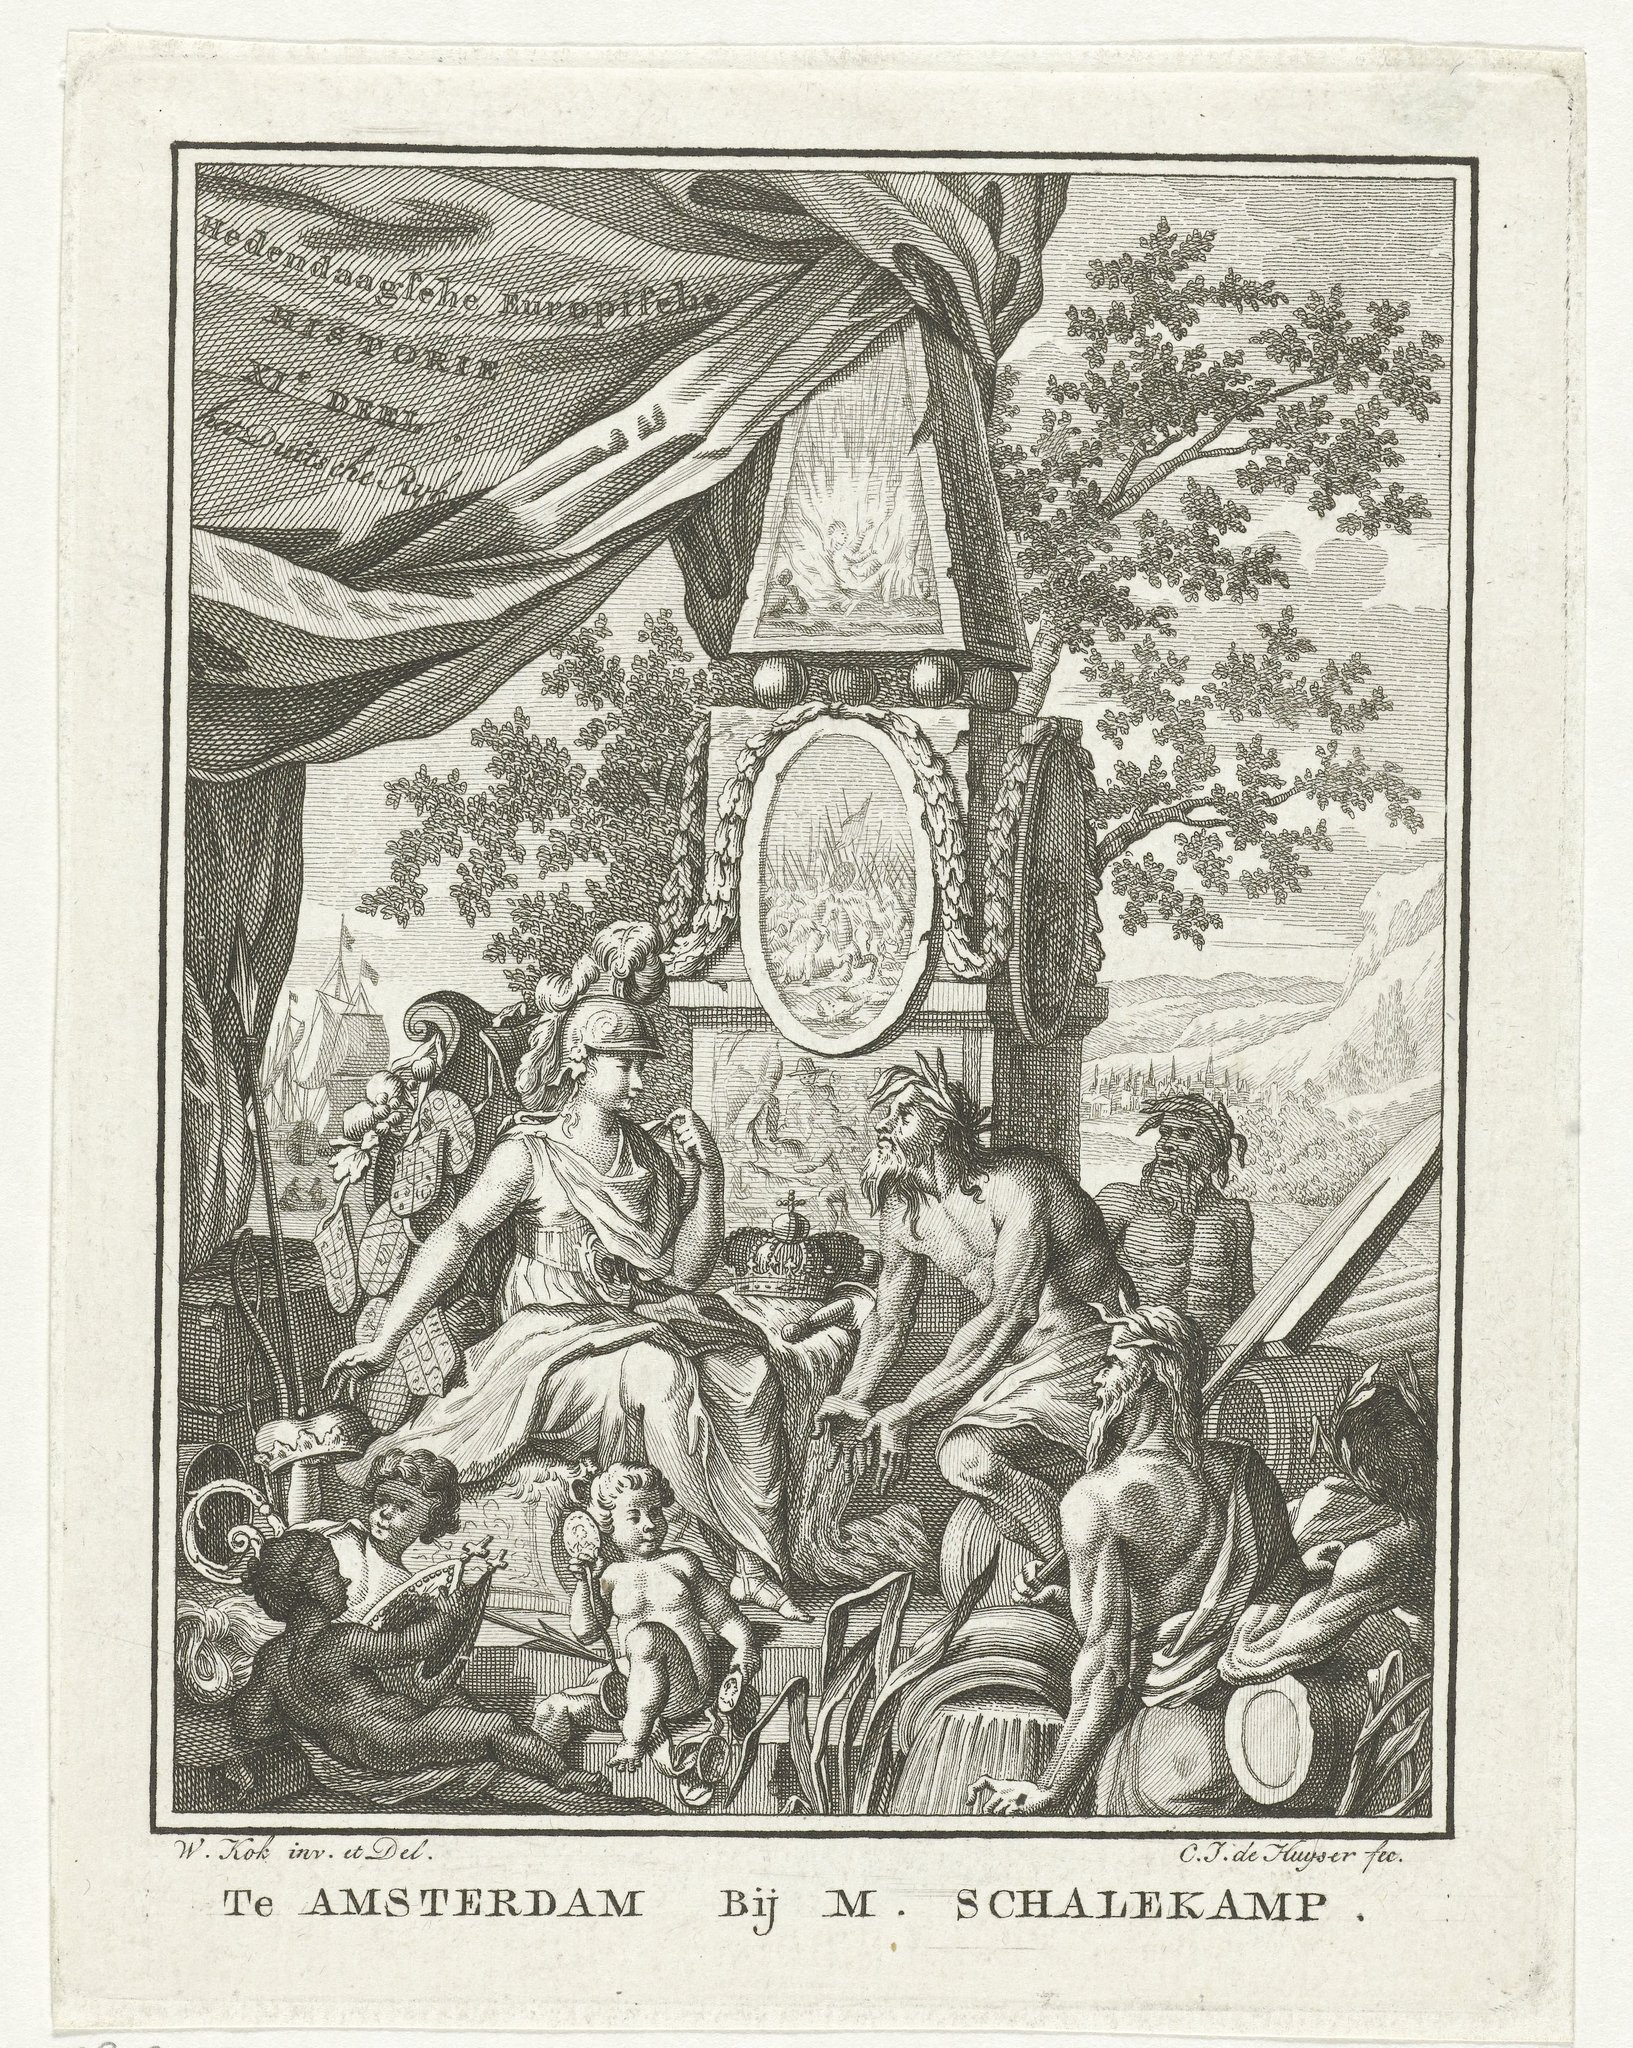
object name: print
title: Titelpagina voor: Hedendaagsche historie (...), 1787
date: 1787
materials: paper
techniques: engraving, etching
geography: amsterdam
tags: obelisk, needle, europeans: germans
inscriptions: collector's mark: Lugt 2228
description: Titelpagina uit: Hedendaagsche historie of Het vervolg van de Algemeene historie (...). XIde deel (...) behelzende de verdere Europische historie, en byzonderlyk die van het Duitsche ryk. Amsterdam: Matthijs Schalekamp, 1787.